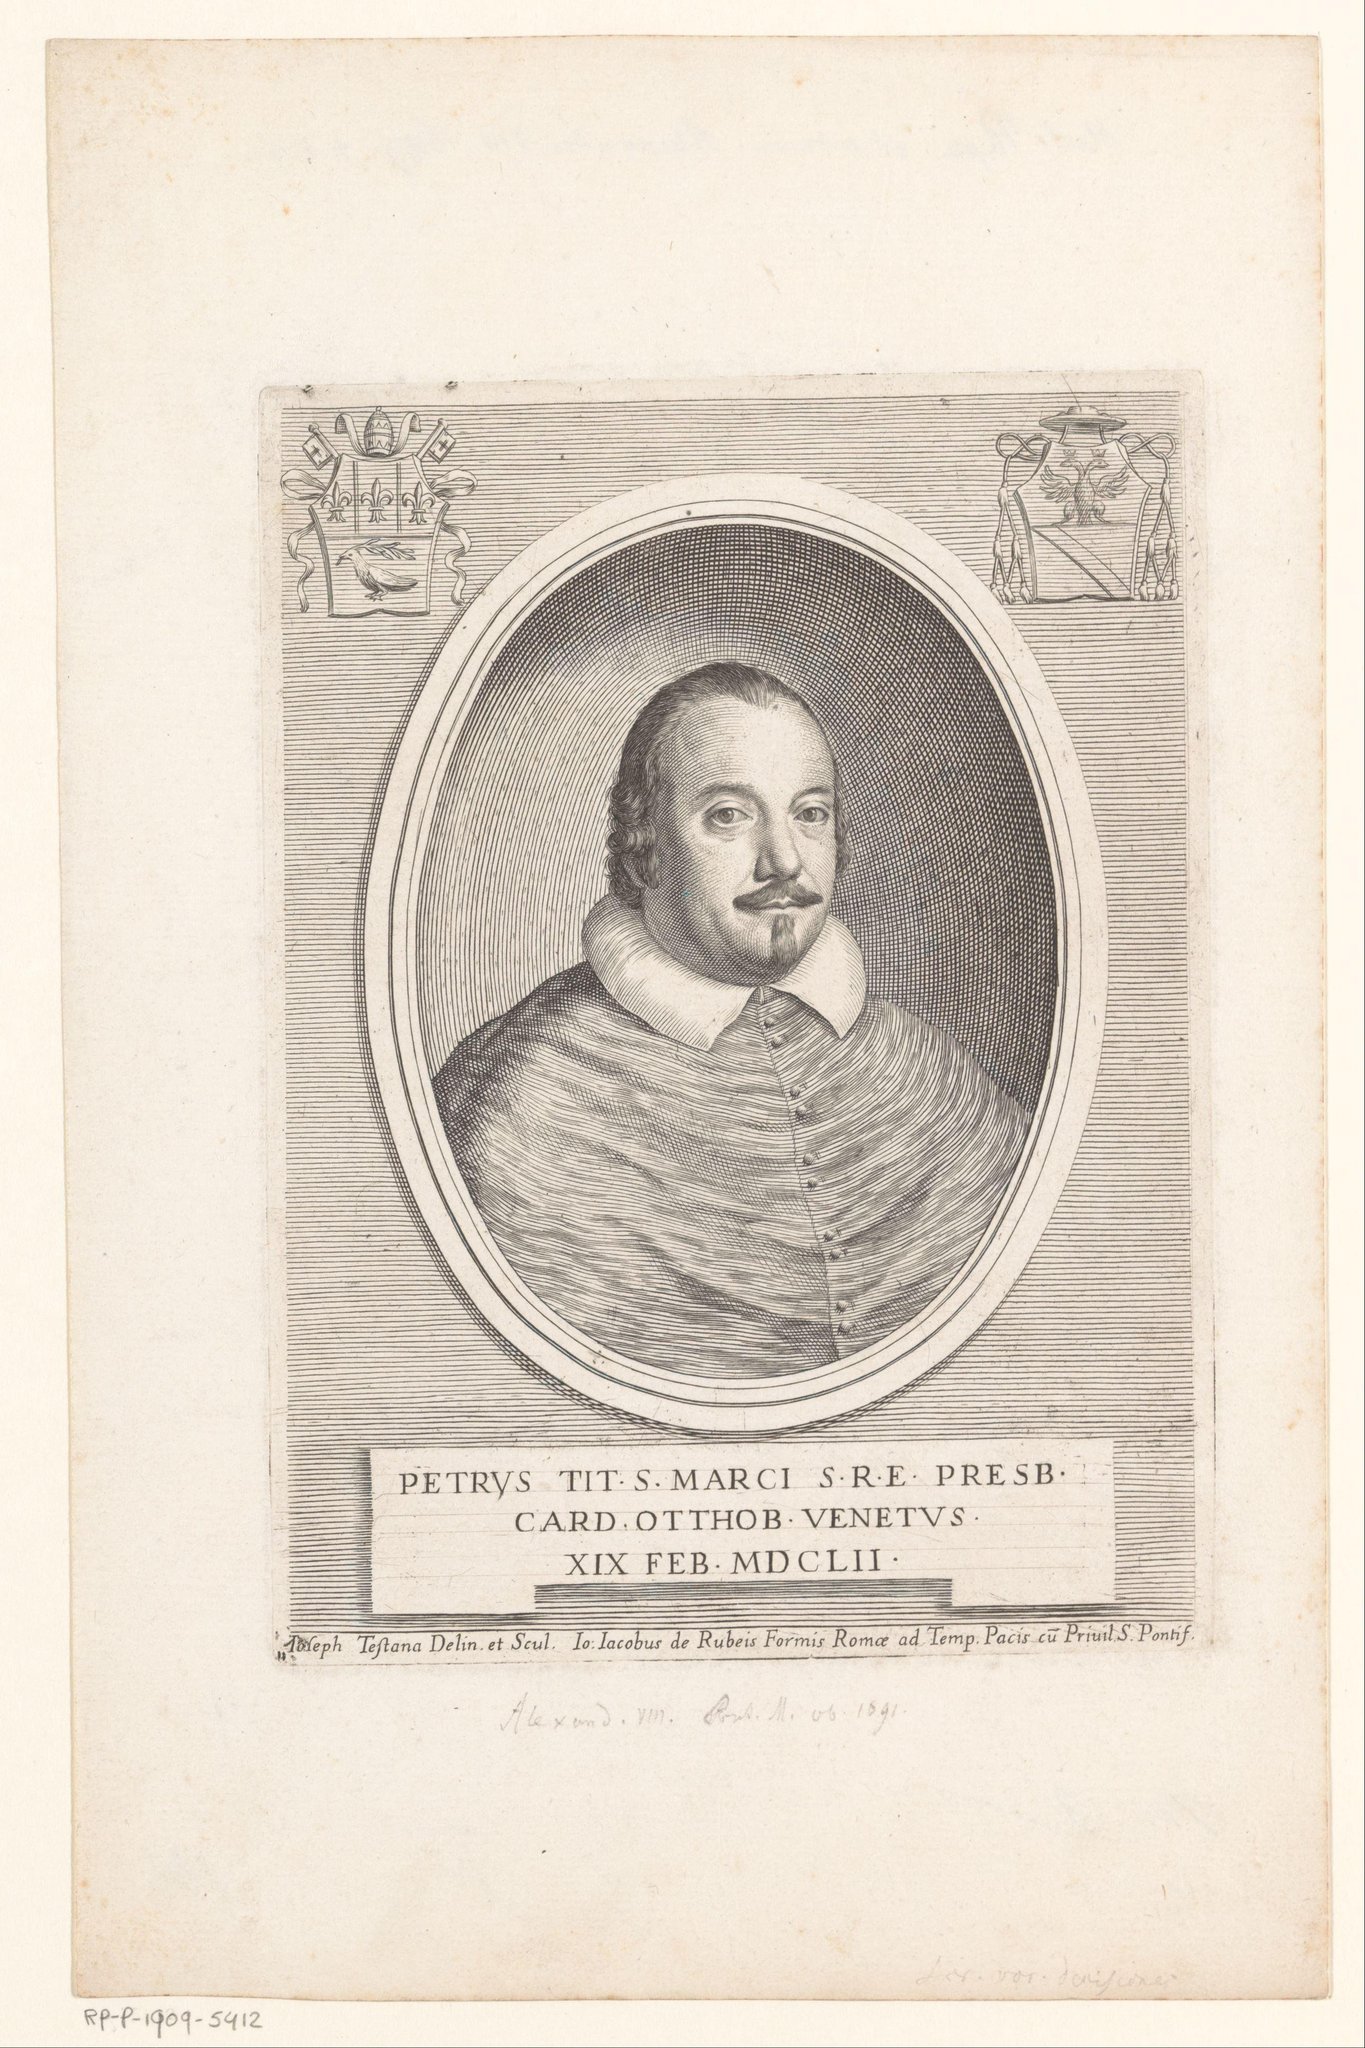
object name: print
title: Portret van paus Alexander VIII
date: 1658-1679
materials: paper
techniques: engraving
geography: italy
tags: venice, clergyman, alexander viii, cardinal, historical persons, pope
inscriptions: collector's mark: Lugt 2228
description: Prent uit een reeks van onbekende omvang met portretten van kardinalen. De prenten werden vanaf 1657 vervaardigd in opdracht van uitgever Giovanni Giacomo de’ Rossi, waarna de productie werd voortgezet onder leiding van zijn opvolgers Domenico de’ Rossi en Lorenzo Filippo de’ Rossi, en ten slotte onder leiding van de Calcographia R.C.A.